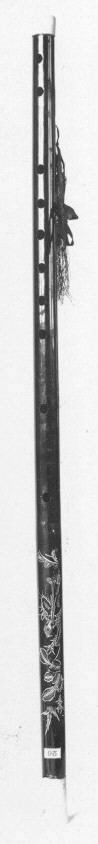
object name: dizi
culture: chinese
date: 1867-1900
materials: bamboo, bone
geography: china